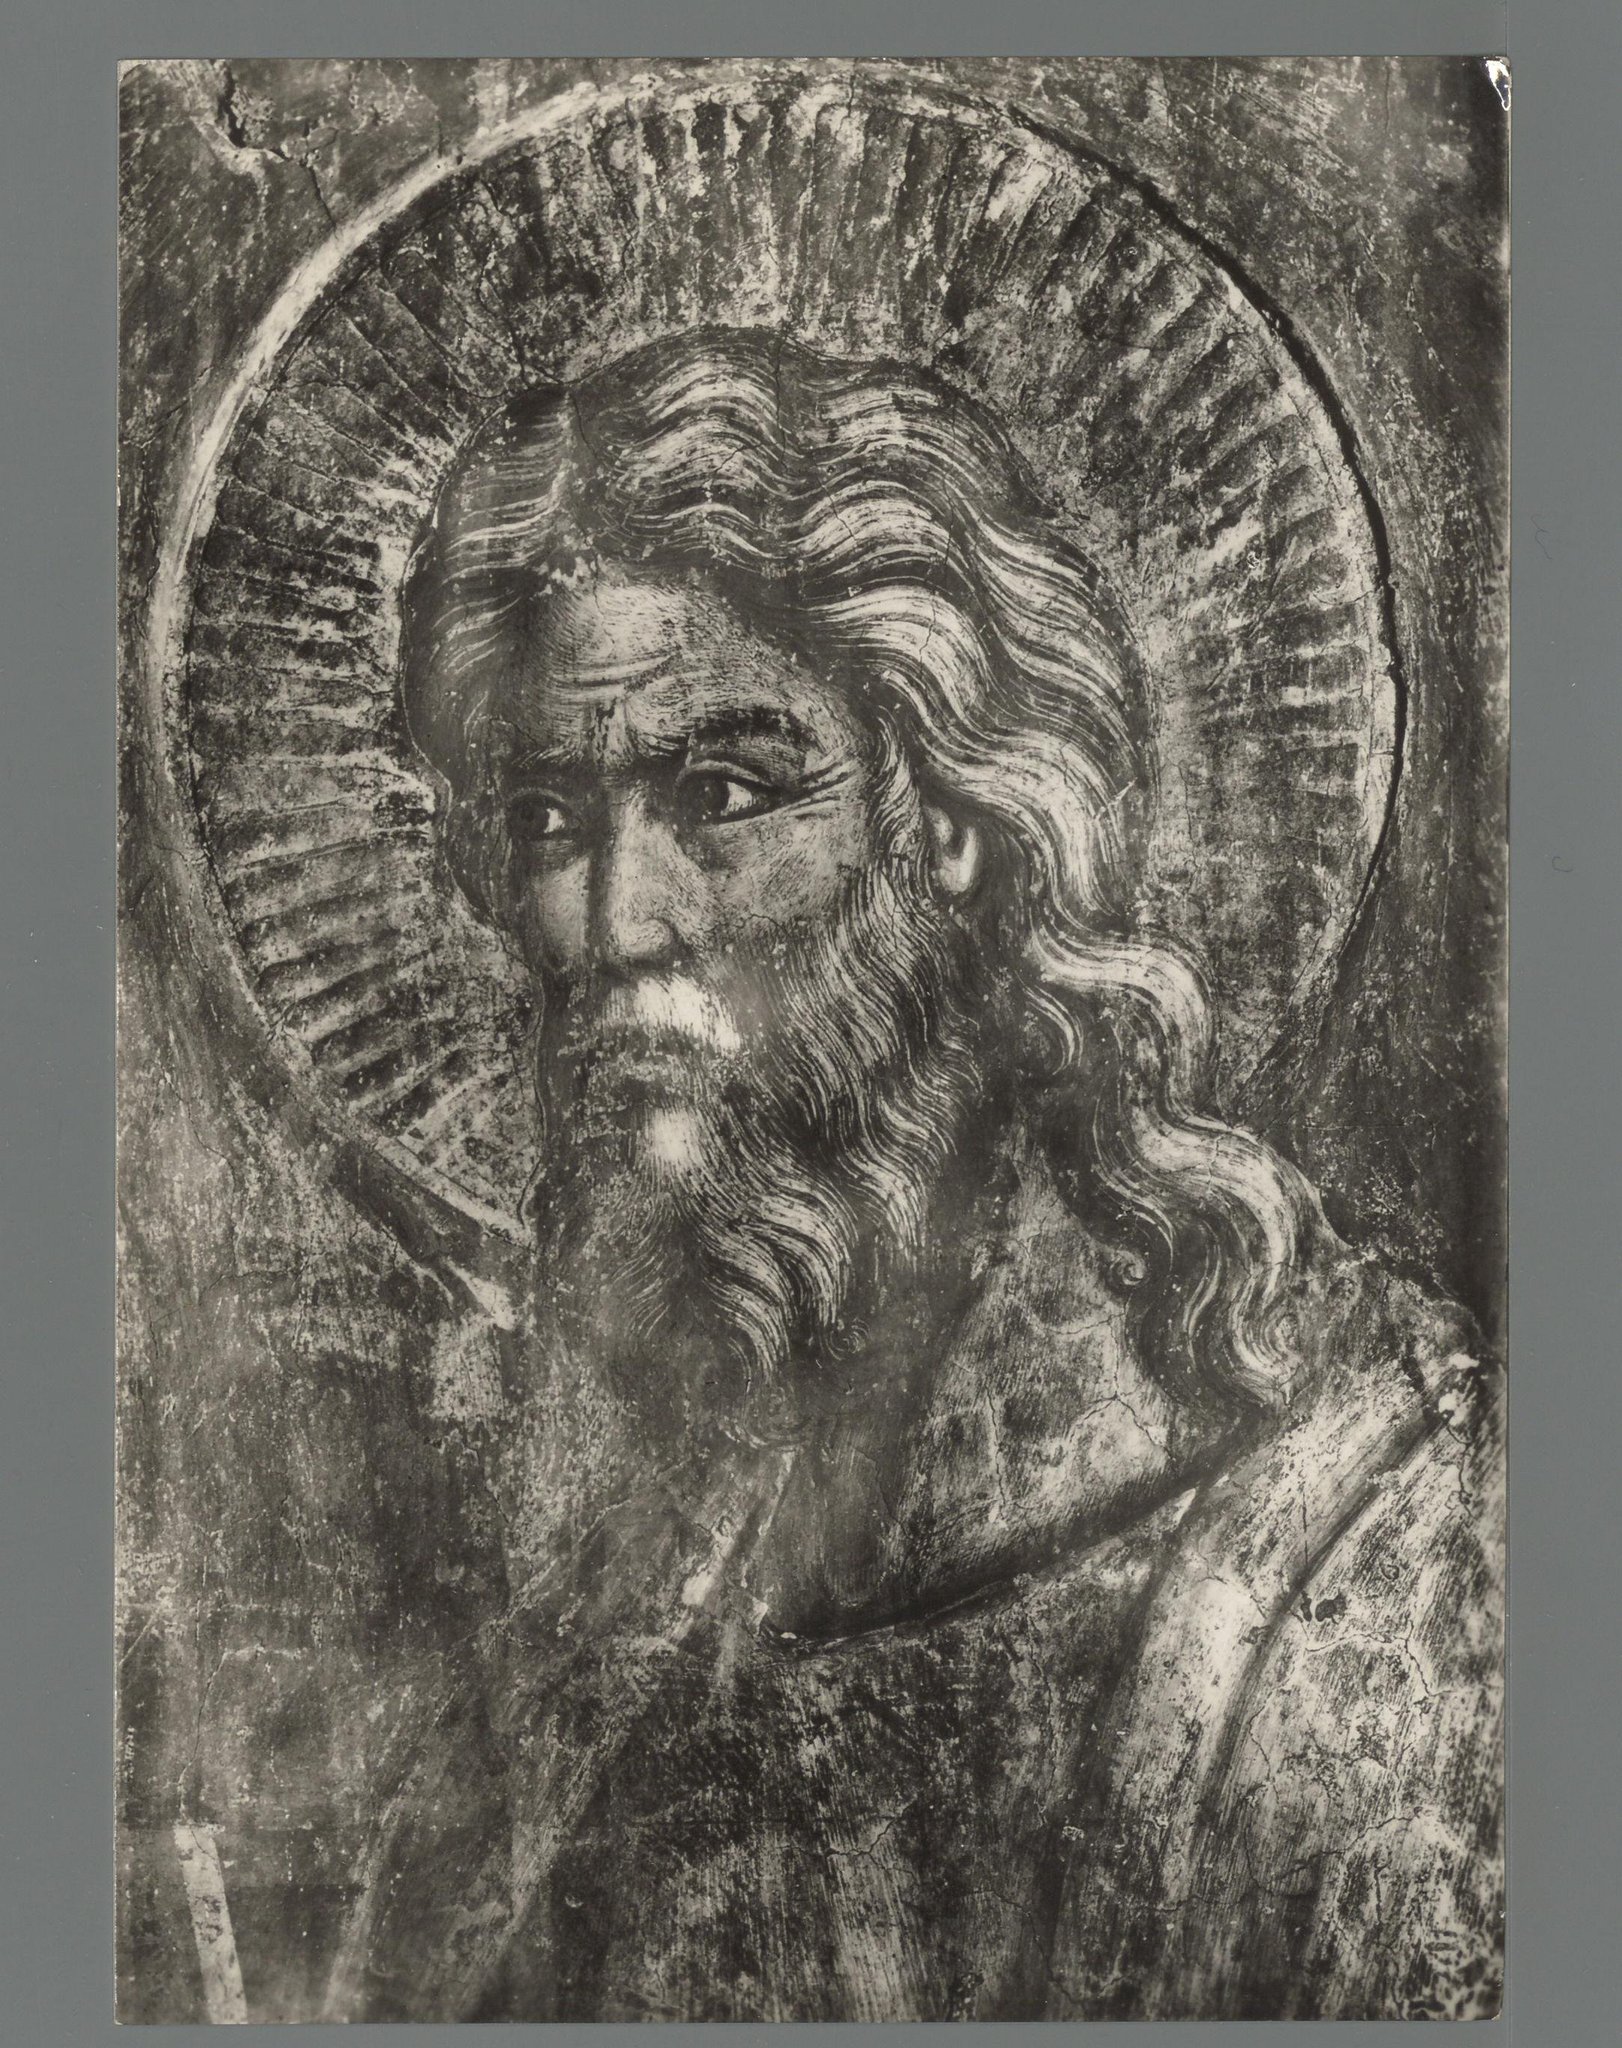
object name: ansichtkaart, prentbriefkaart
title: Roma. Convento di S. Cecilia. Un apostolo. Partic. del Giudizio Finale (P. Cavallini)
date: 1950-1975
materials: photographic support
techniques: photography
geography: rome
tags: (single) apostle, unspecified